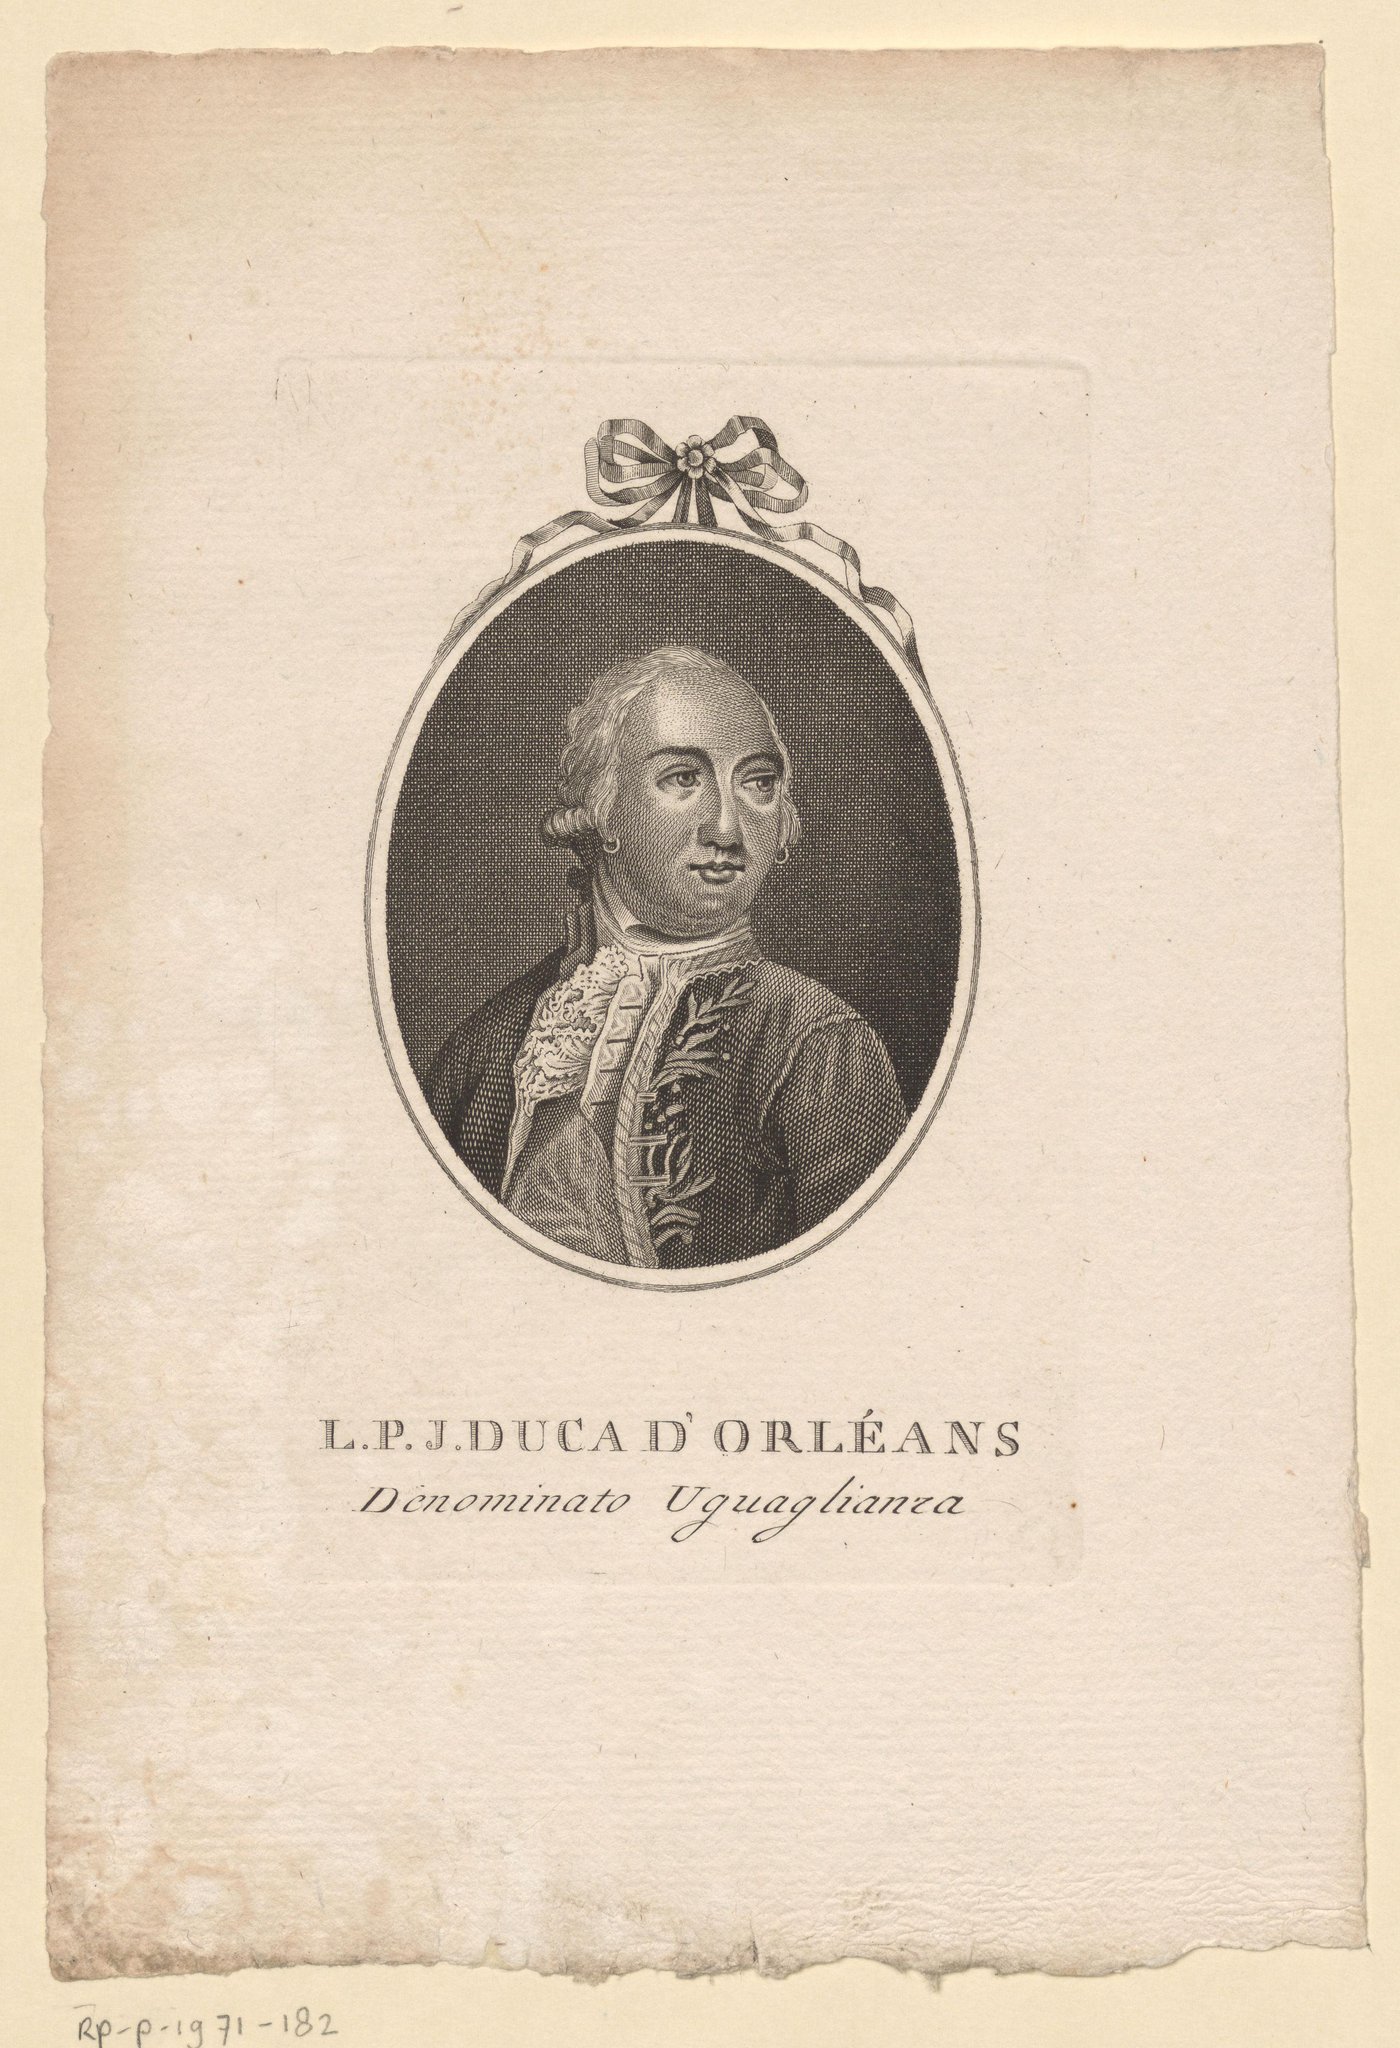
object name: print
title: Portret van Lodewijk Filips II van Orléans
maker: Anonymous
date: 1792-1799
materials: paper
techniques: etching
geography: italy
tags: lodewijk filips ii (hertog van orléans), ornament ~ medallion, historical persons, ear-rings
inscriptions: collector's mark: Lugt 2760, collector's mark: Lugt 2228